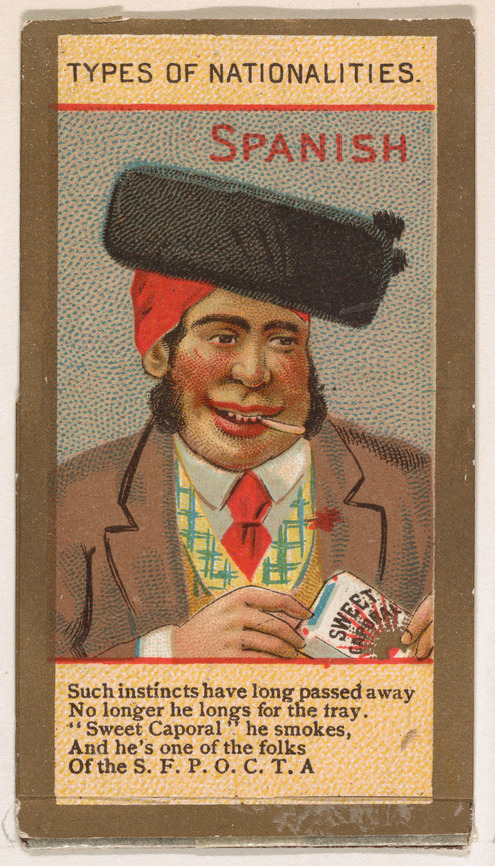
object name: print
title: Spanish, from Types of Nationalities (N240) issued by Kinney Bros.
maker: kinney brothers tobacco company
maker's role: publisher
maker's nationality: american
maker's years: 1869-2011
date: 1890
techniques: color lithograph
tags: men,smoking